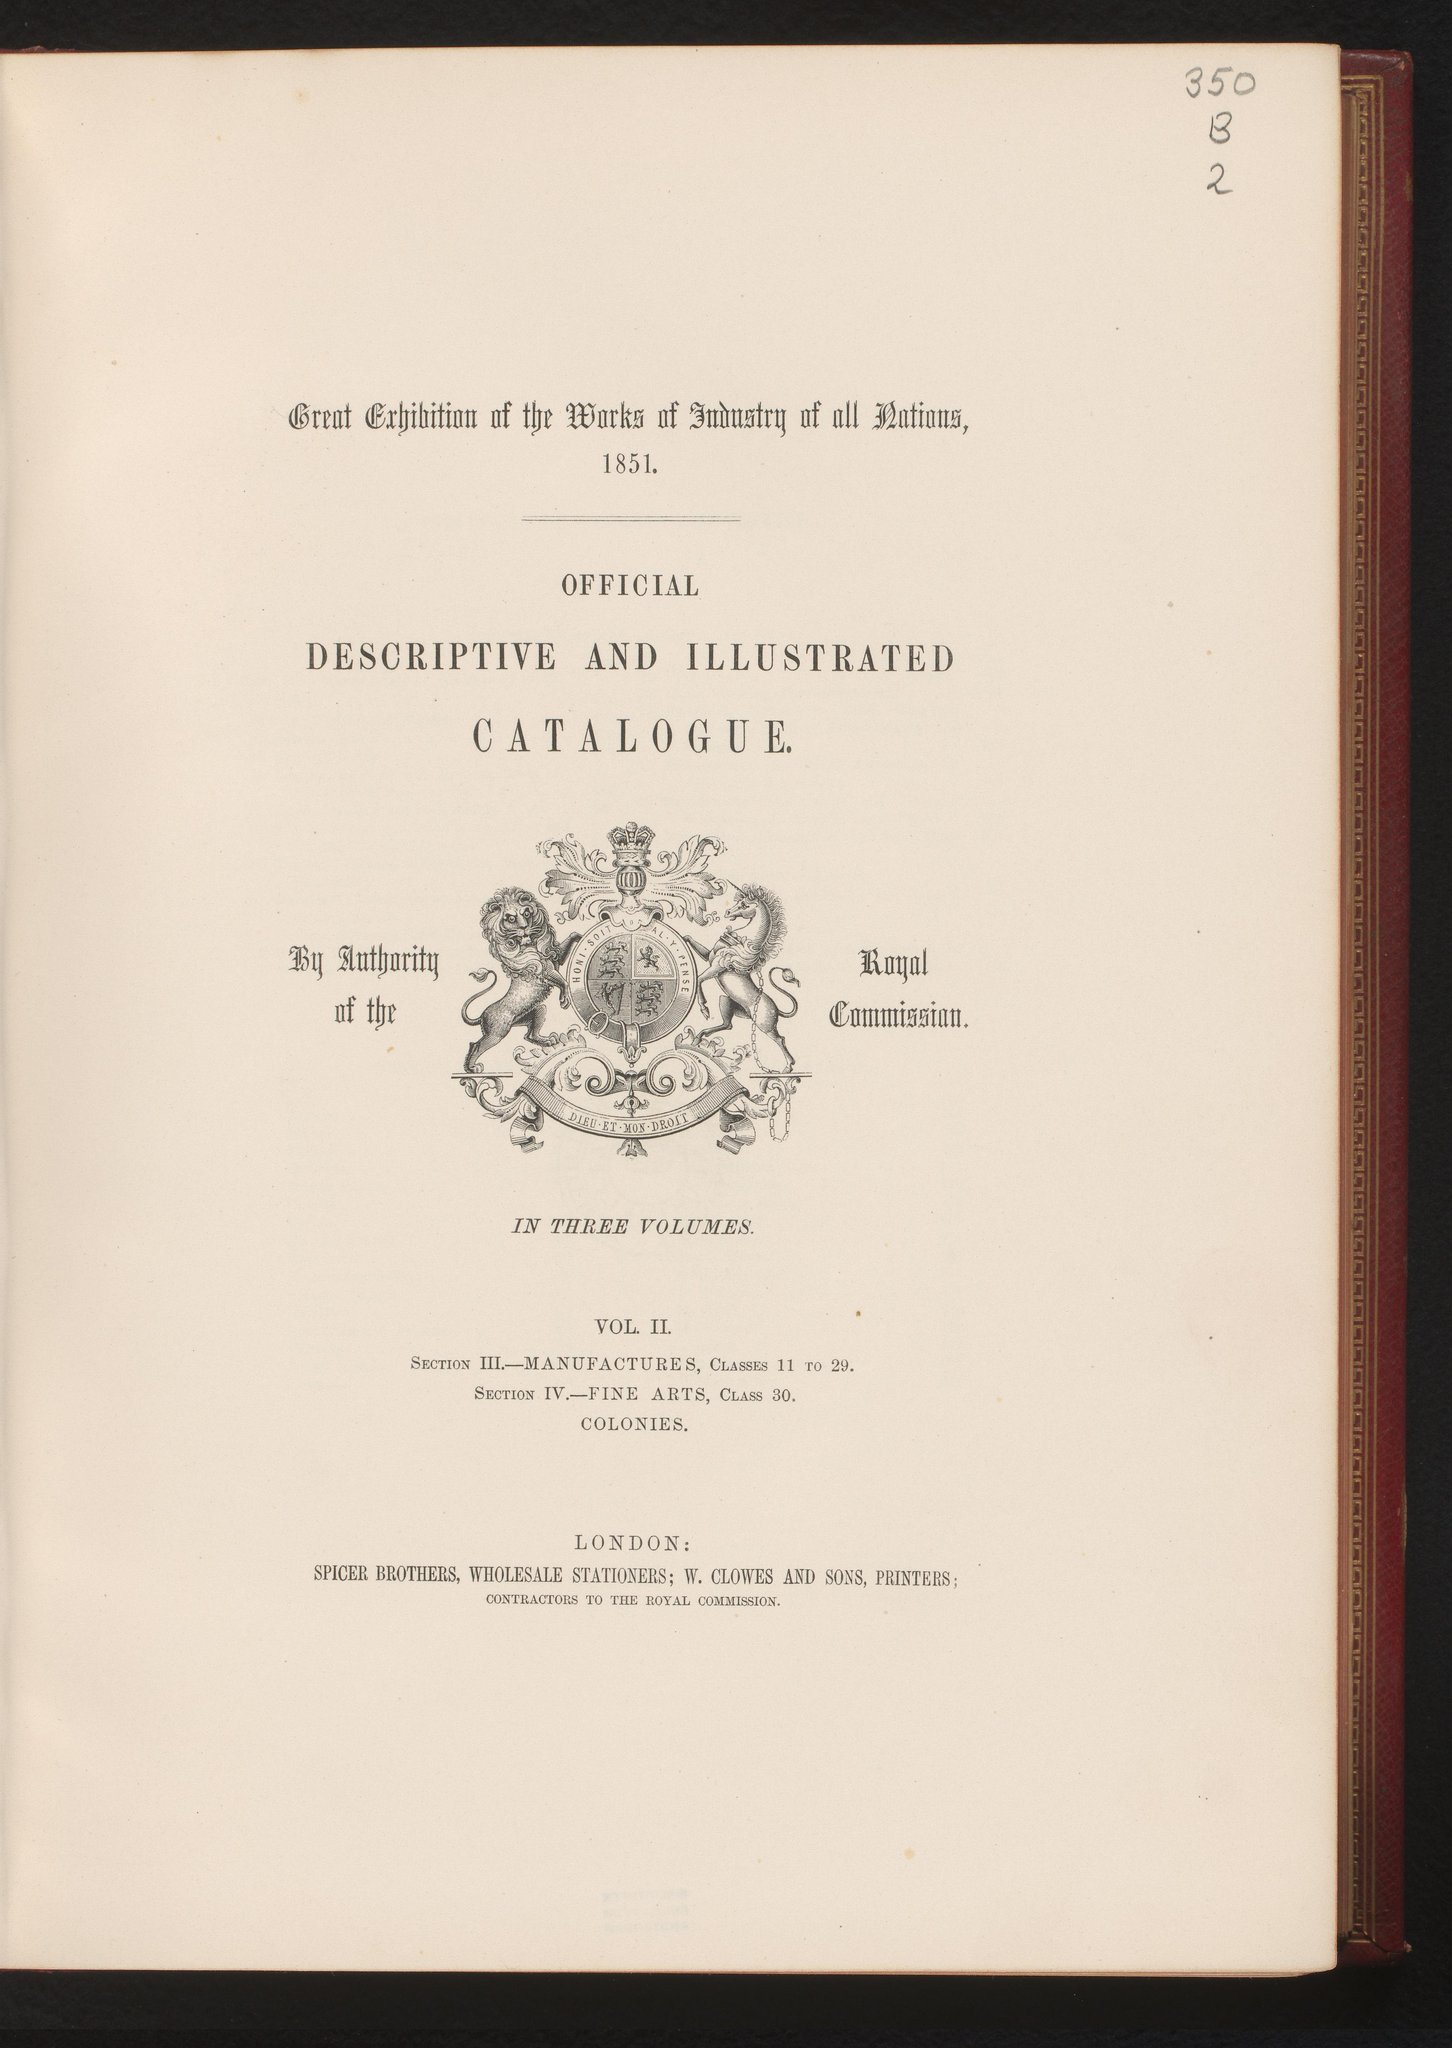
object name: book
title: Great exhibition of the works of industry of all nations 1851: official descriptive and illustrated catalogue - vol. II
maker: robert riviere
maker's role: boekbinder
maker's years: 1808-1882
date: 1851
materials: cardboard, leather, paper, silk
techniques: engraving, letterpress printing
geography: london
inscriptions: stamp: ‘Grosherzorgliche Bibliothek/ Neustrelitz’, inscription: ‘593, d. [doorgestreept]/ 10.’